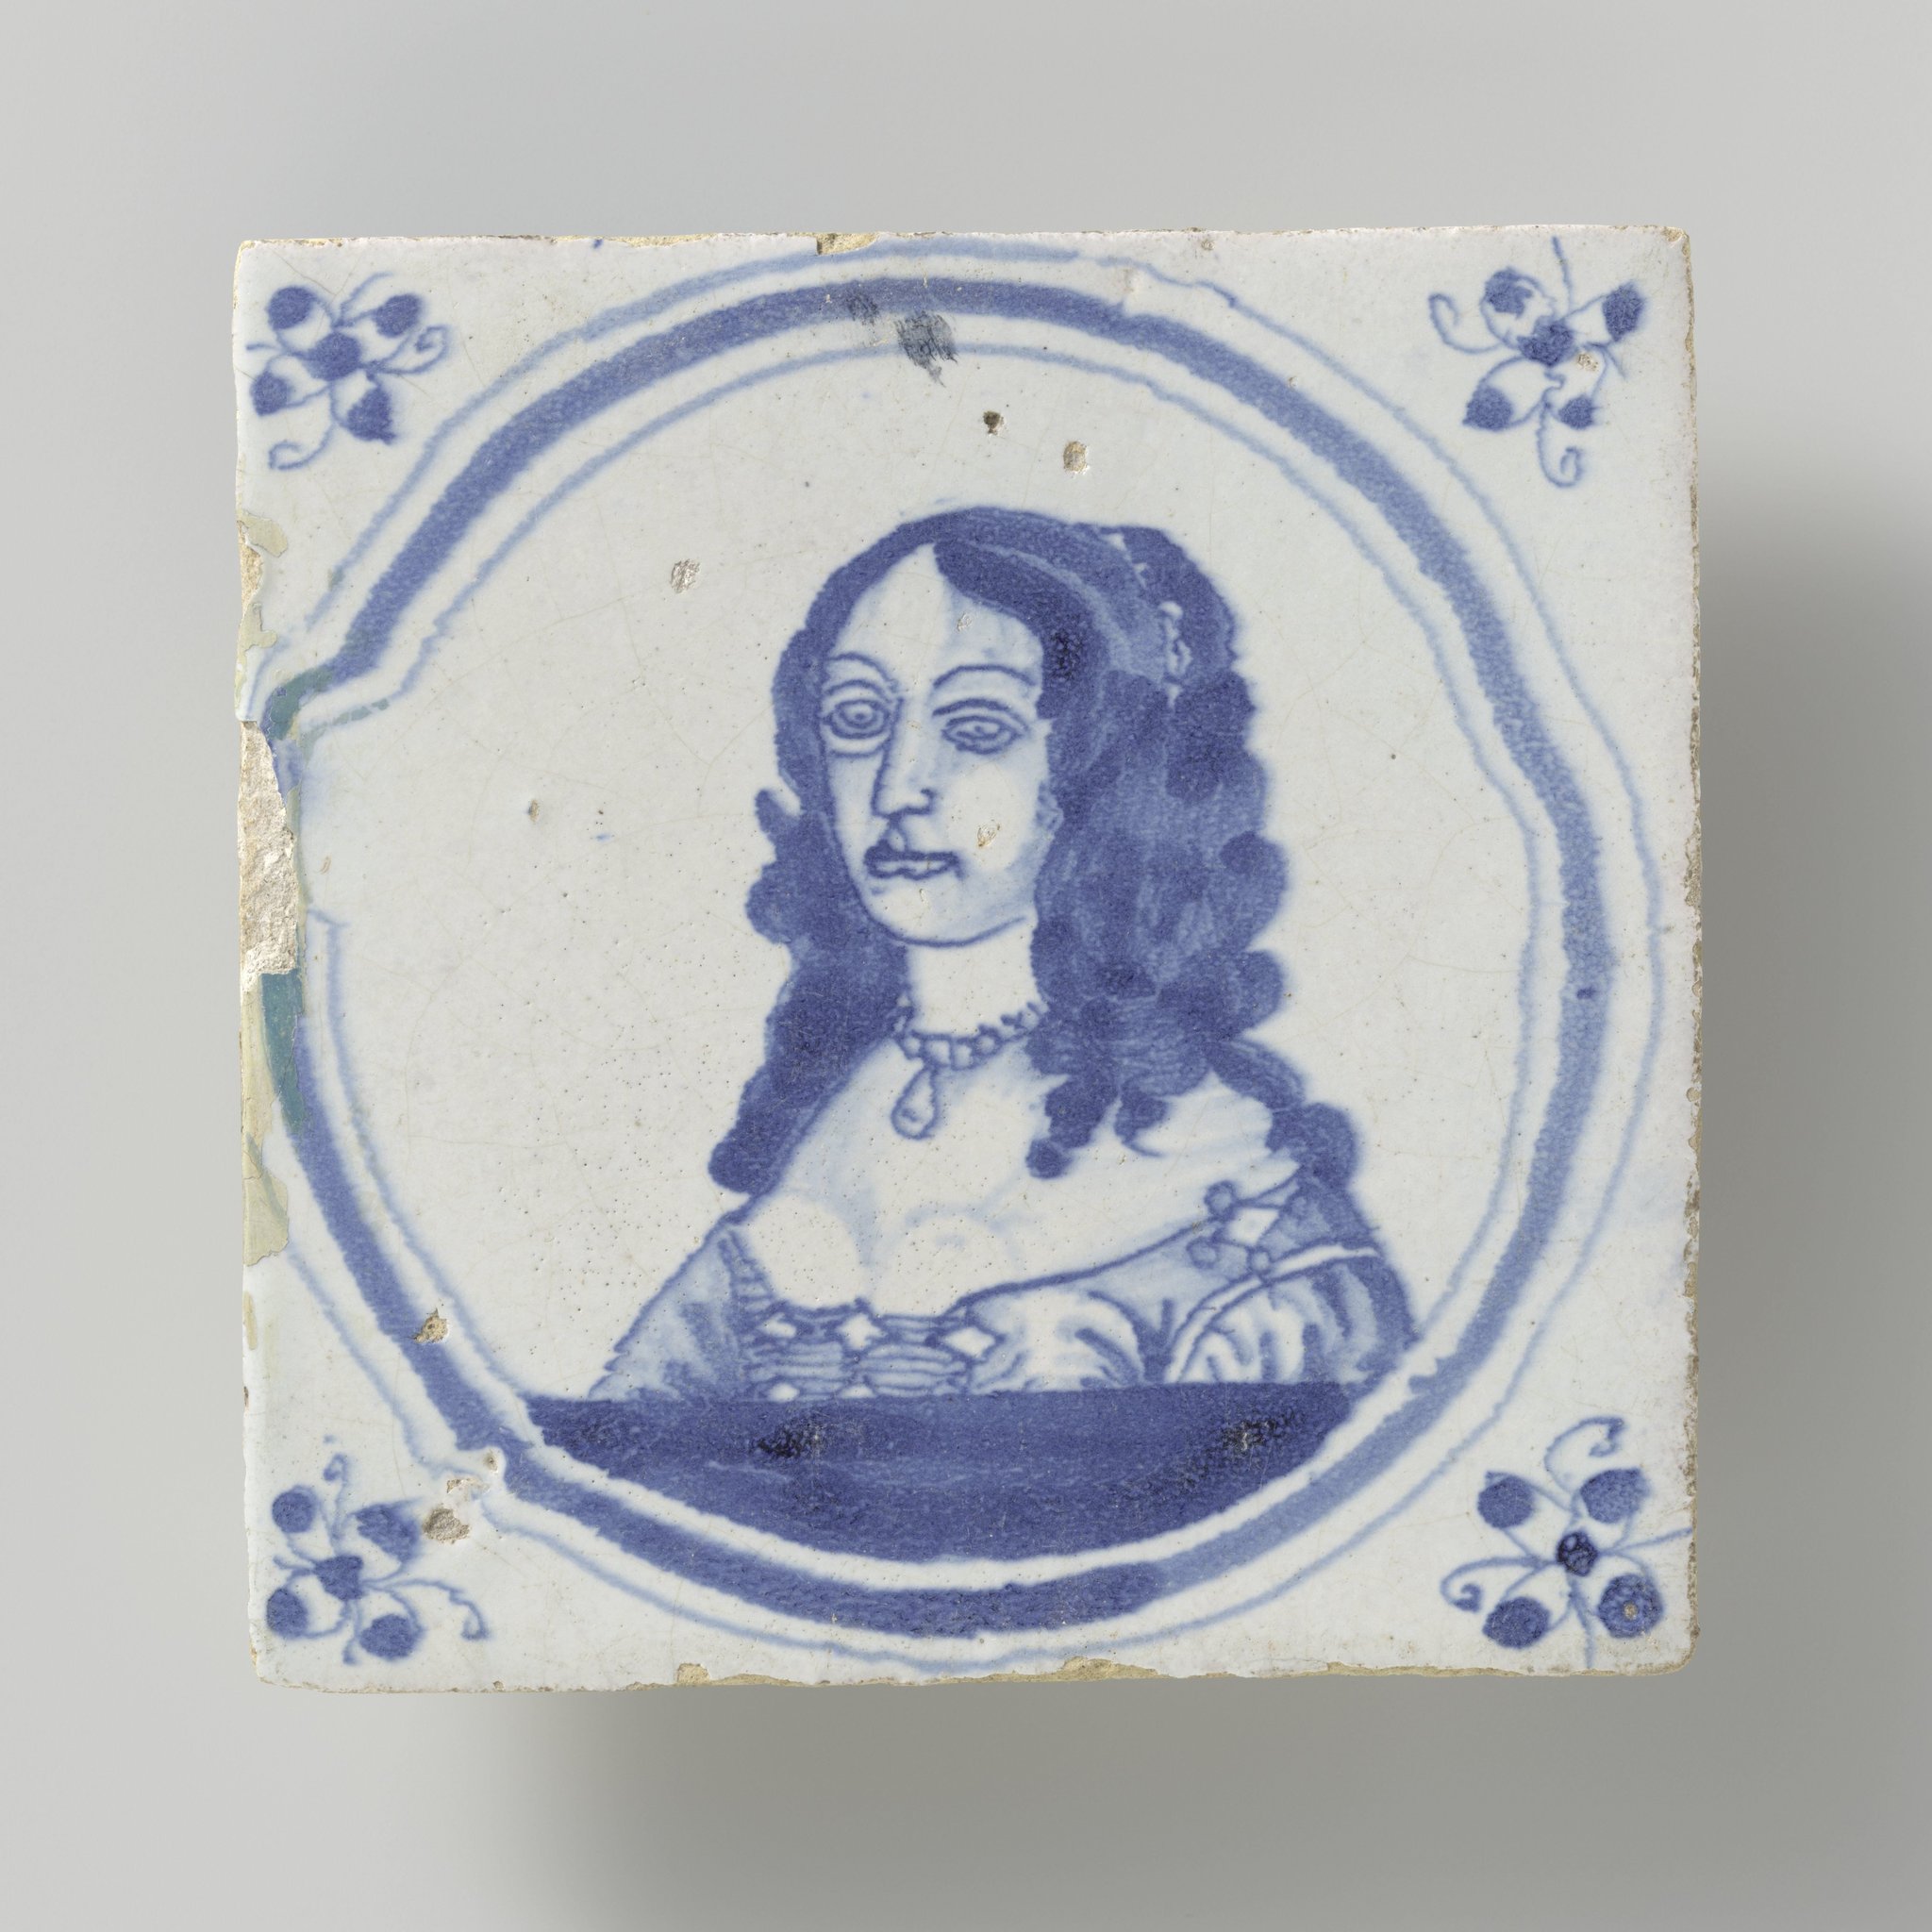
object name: tile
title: Tegel met portret van Amalia van Solms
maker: Anonymous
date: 1650-1670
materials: earthenware, glaze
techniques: maiolica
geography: netherlands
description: Tegel met een blauw geschilderd portret van Amalia van Solms binnen een cirkel met in de hoeken, een spinnetje.